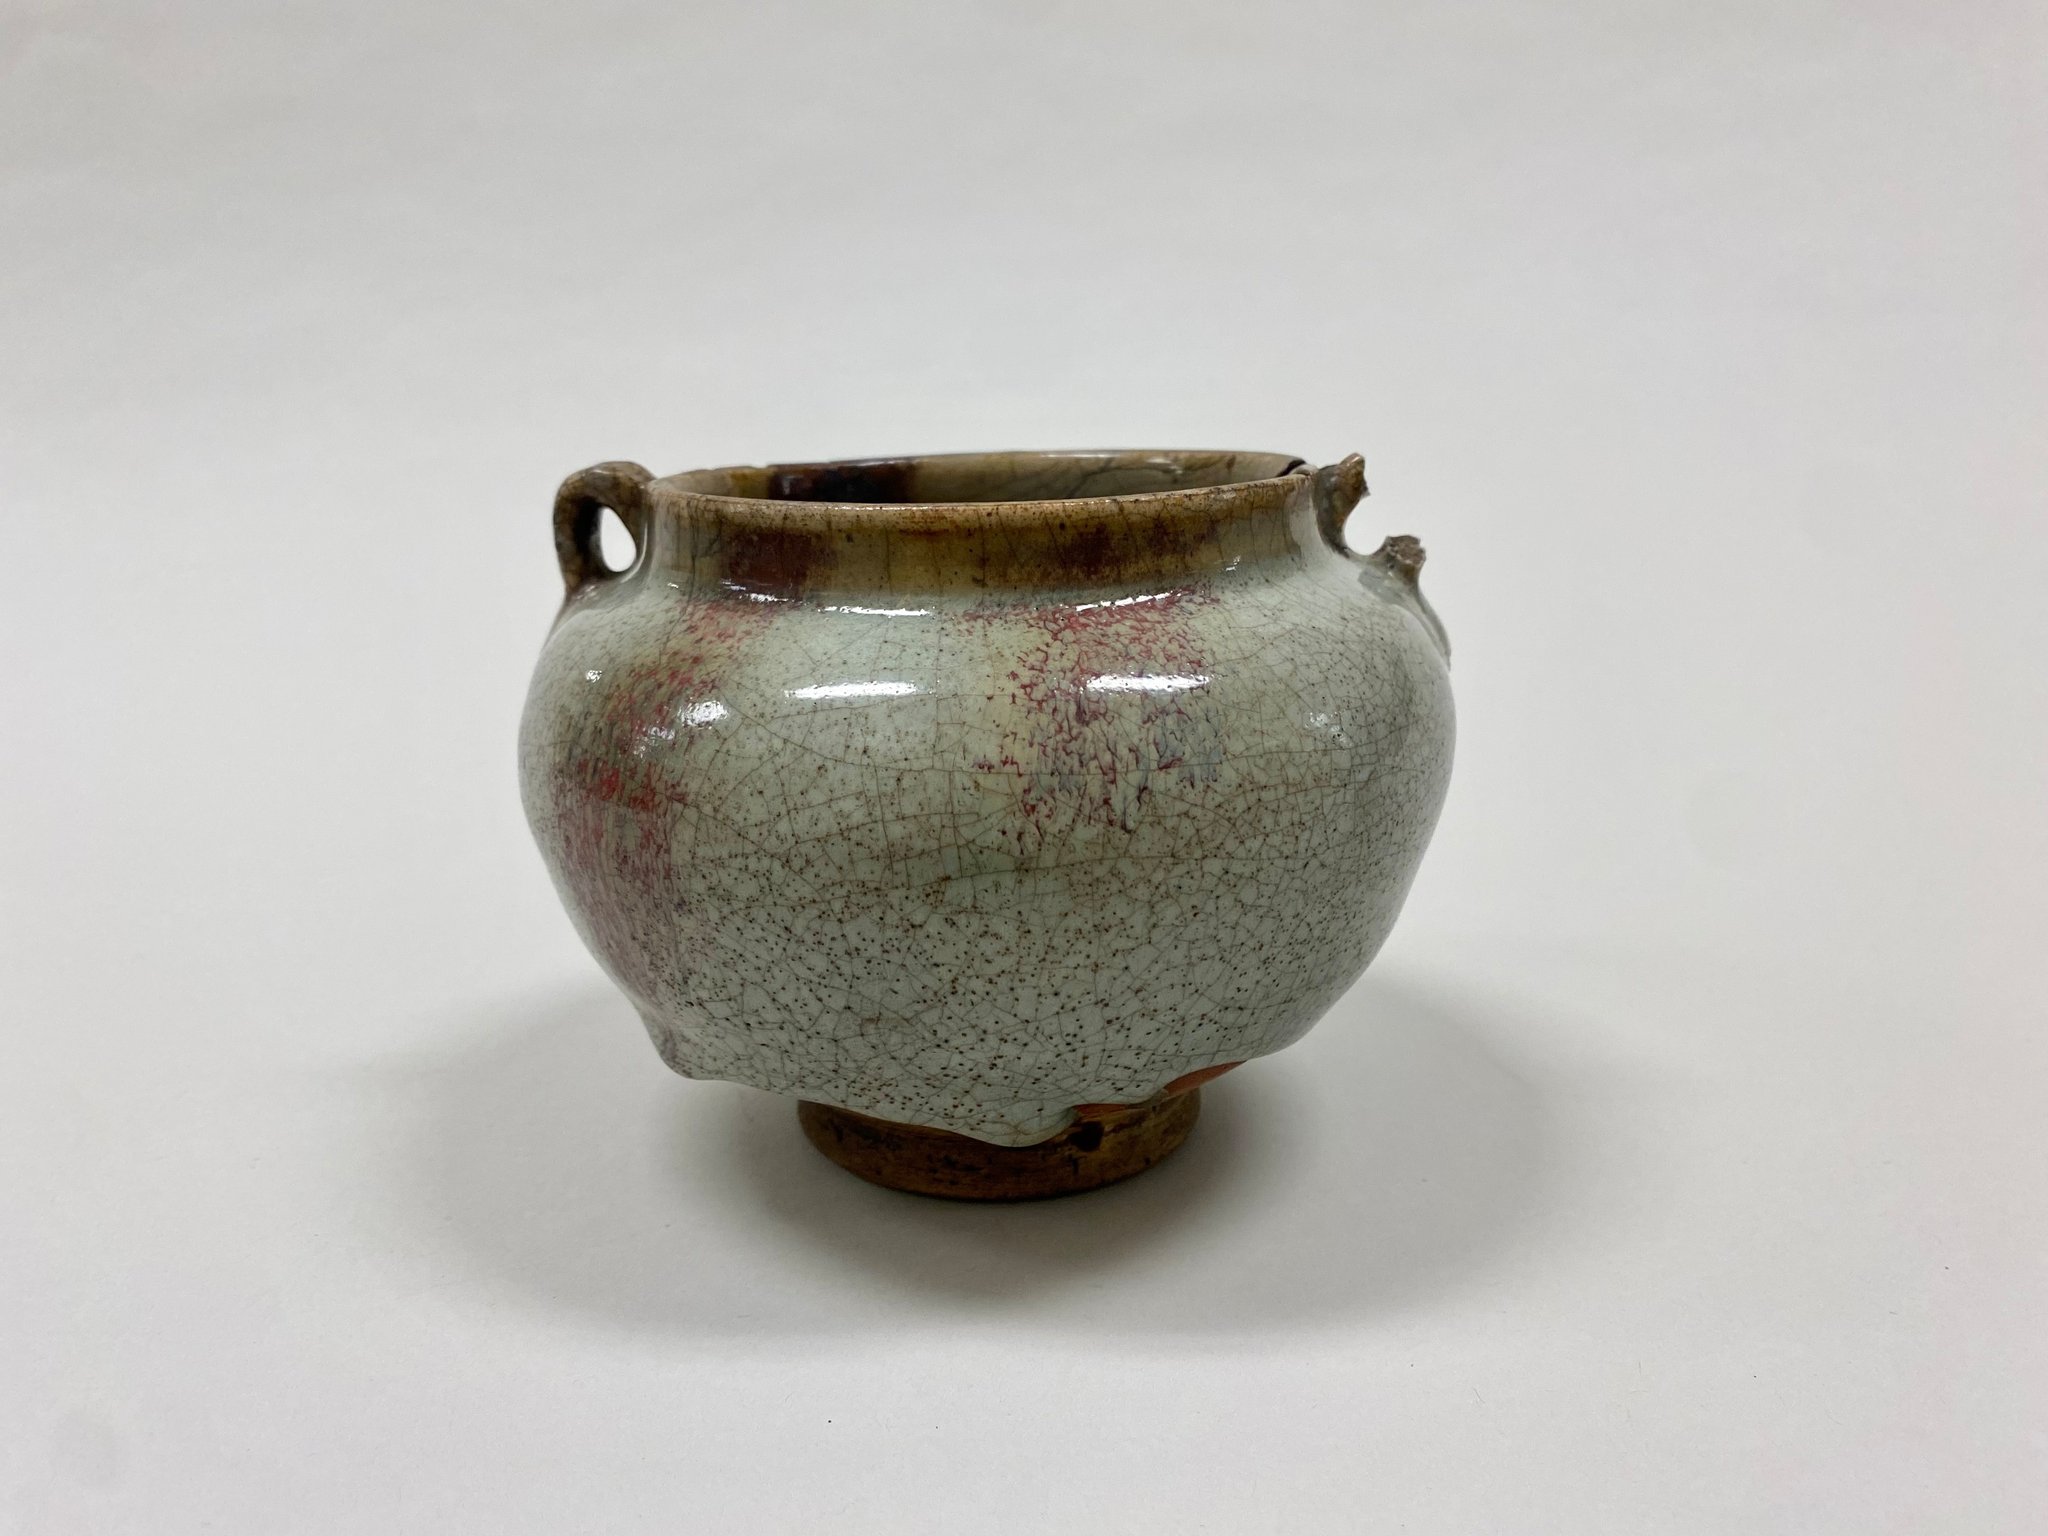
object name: jar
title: Jar with two lugs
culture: chinese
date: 1201-1400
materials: glaze, stoneware